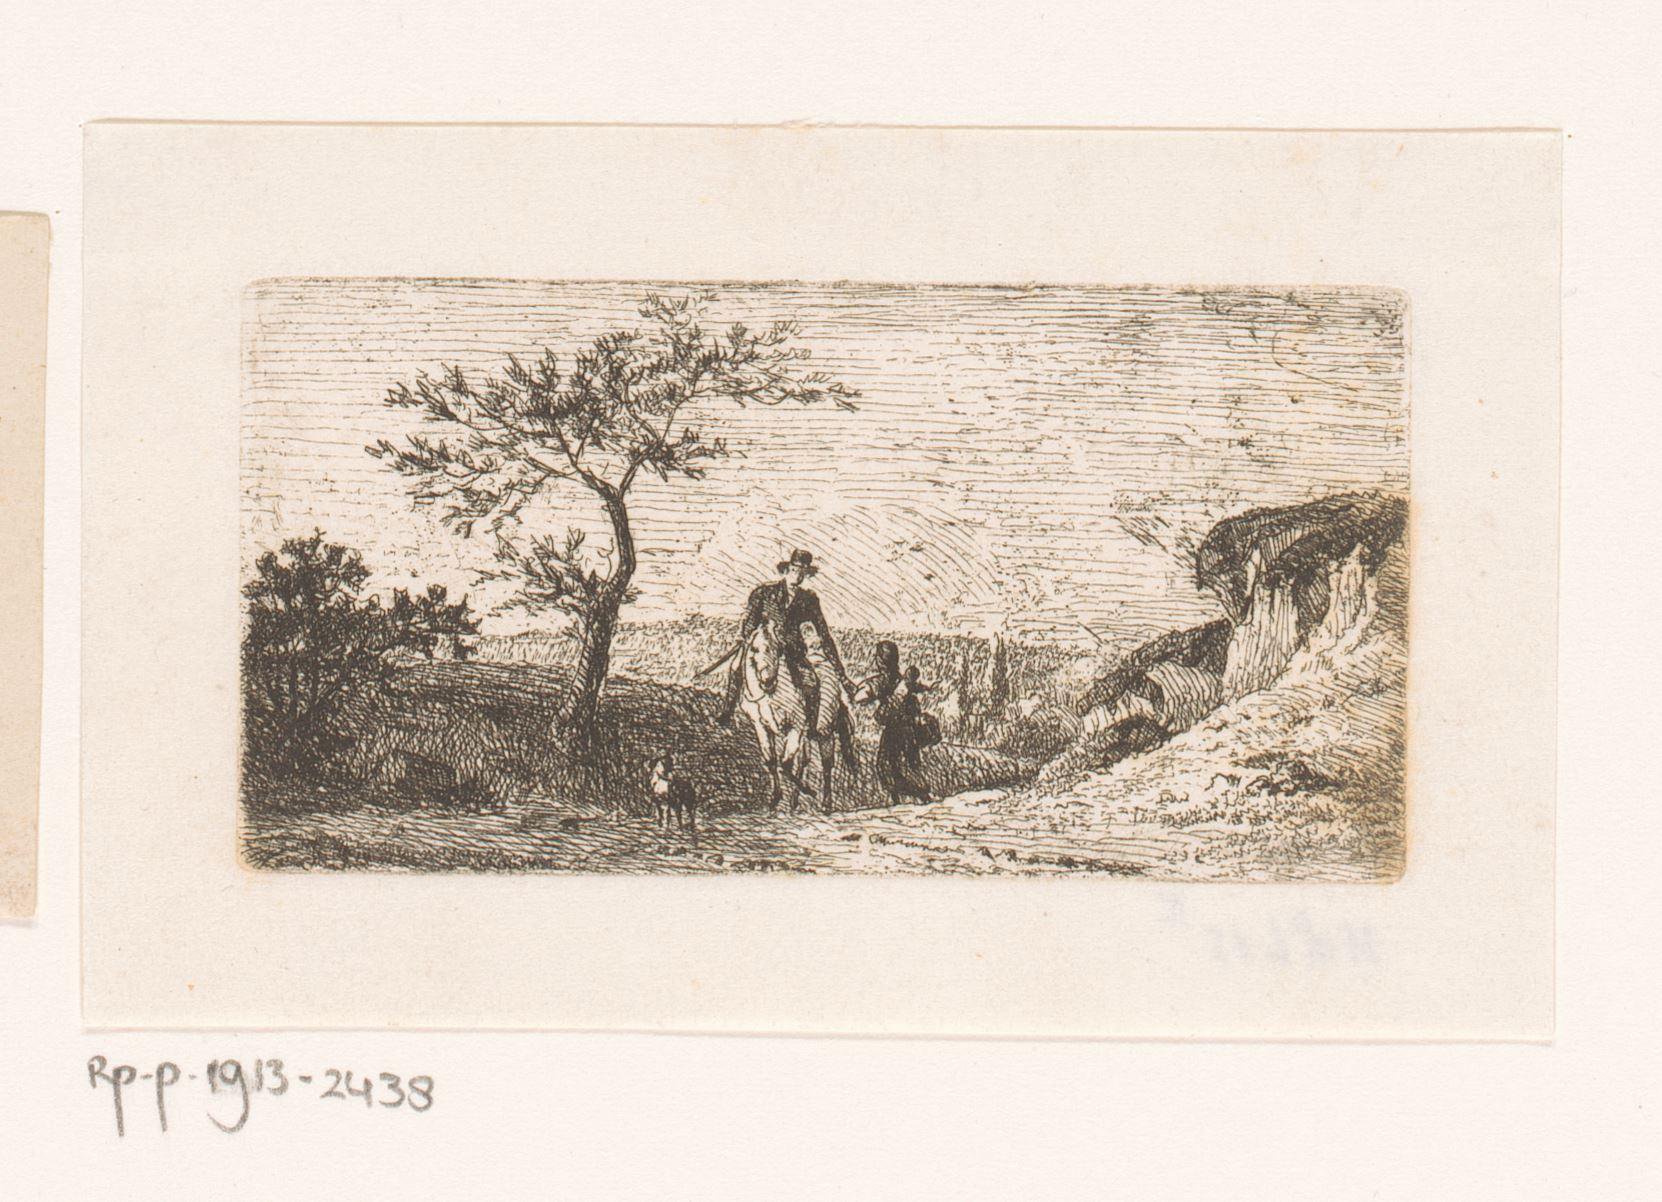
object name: print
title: Landschap met ruiter en bedelaarster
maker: hendrik jozef franciscus van der poorten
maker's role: draughtsman, print maker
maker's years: 1789-1874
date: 1799-1874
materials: paper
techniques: etching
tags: riding a horse, ass, or mule; rider, horseman, road, path, beggar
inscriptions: collector's mark: Lugt 2228, collector's mark: Lugt 1485